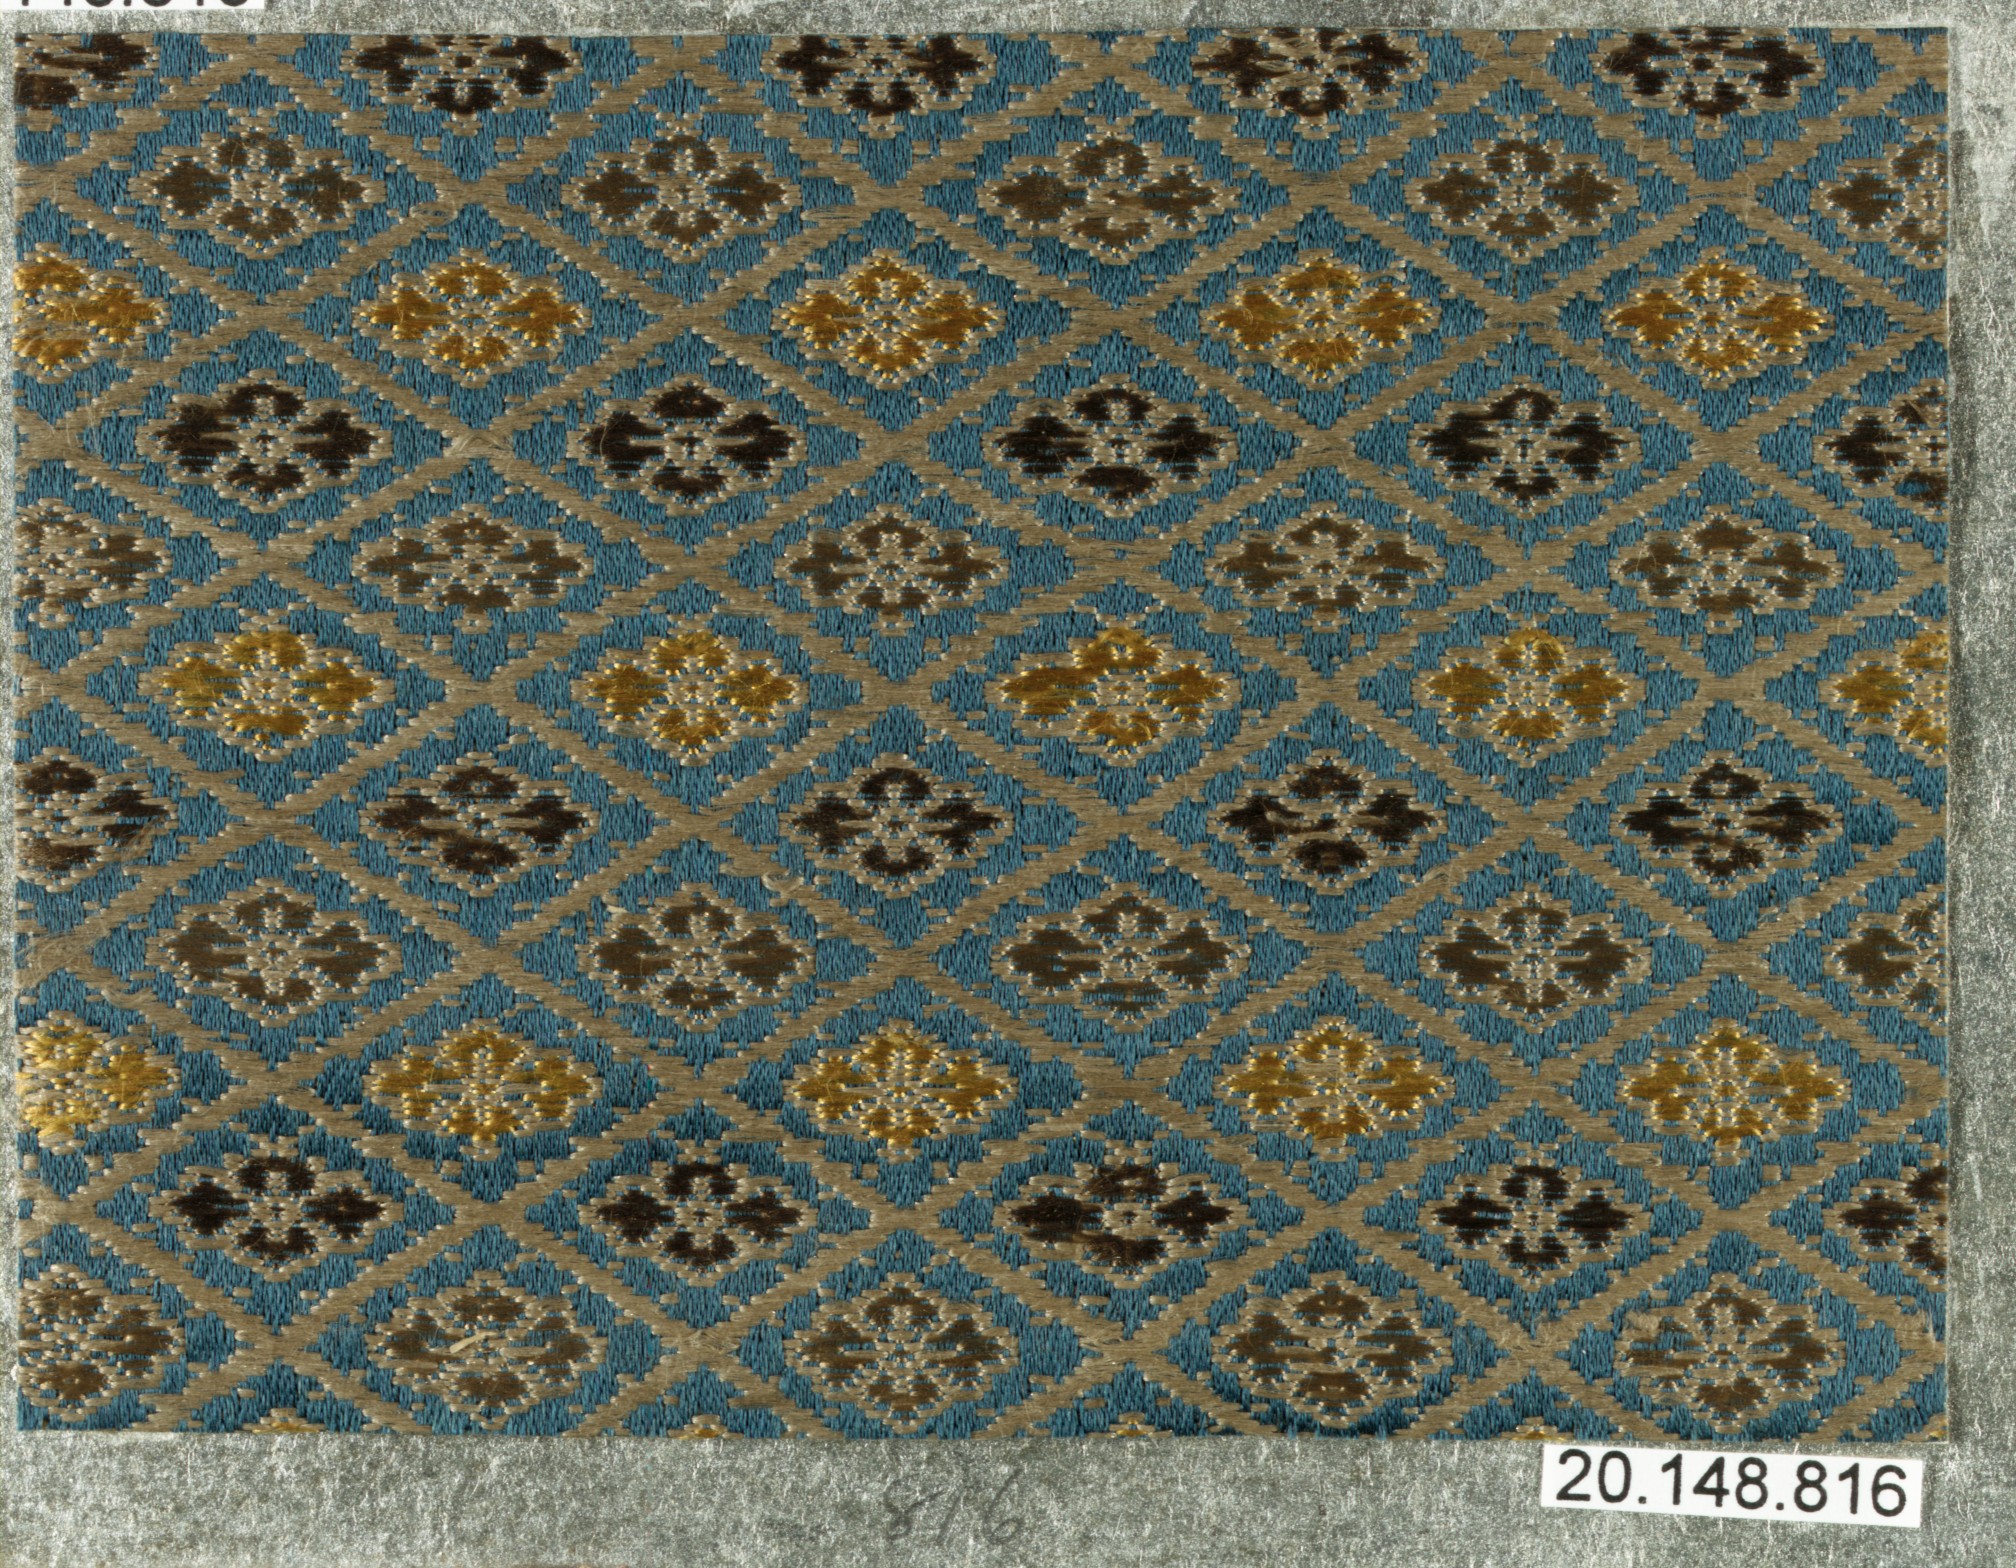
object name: piece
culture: japanese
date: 1701-1800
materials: silk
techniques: compound weave